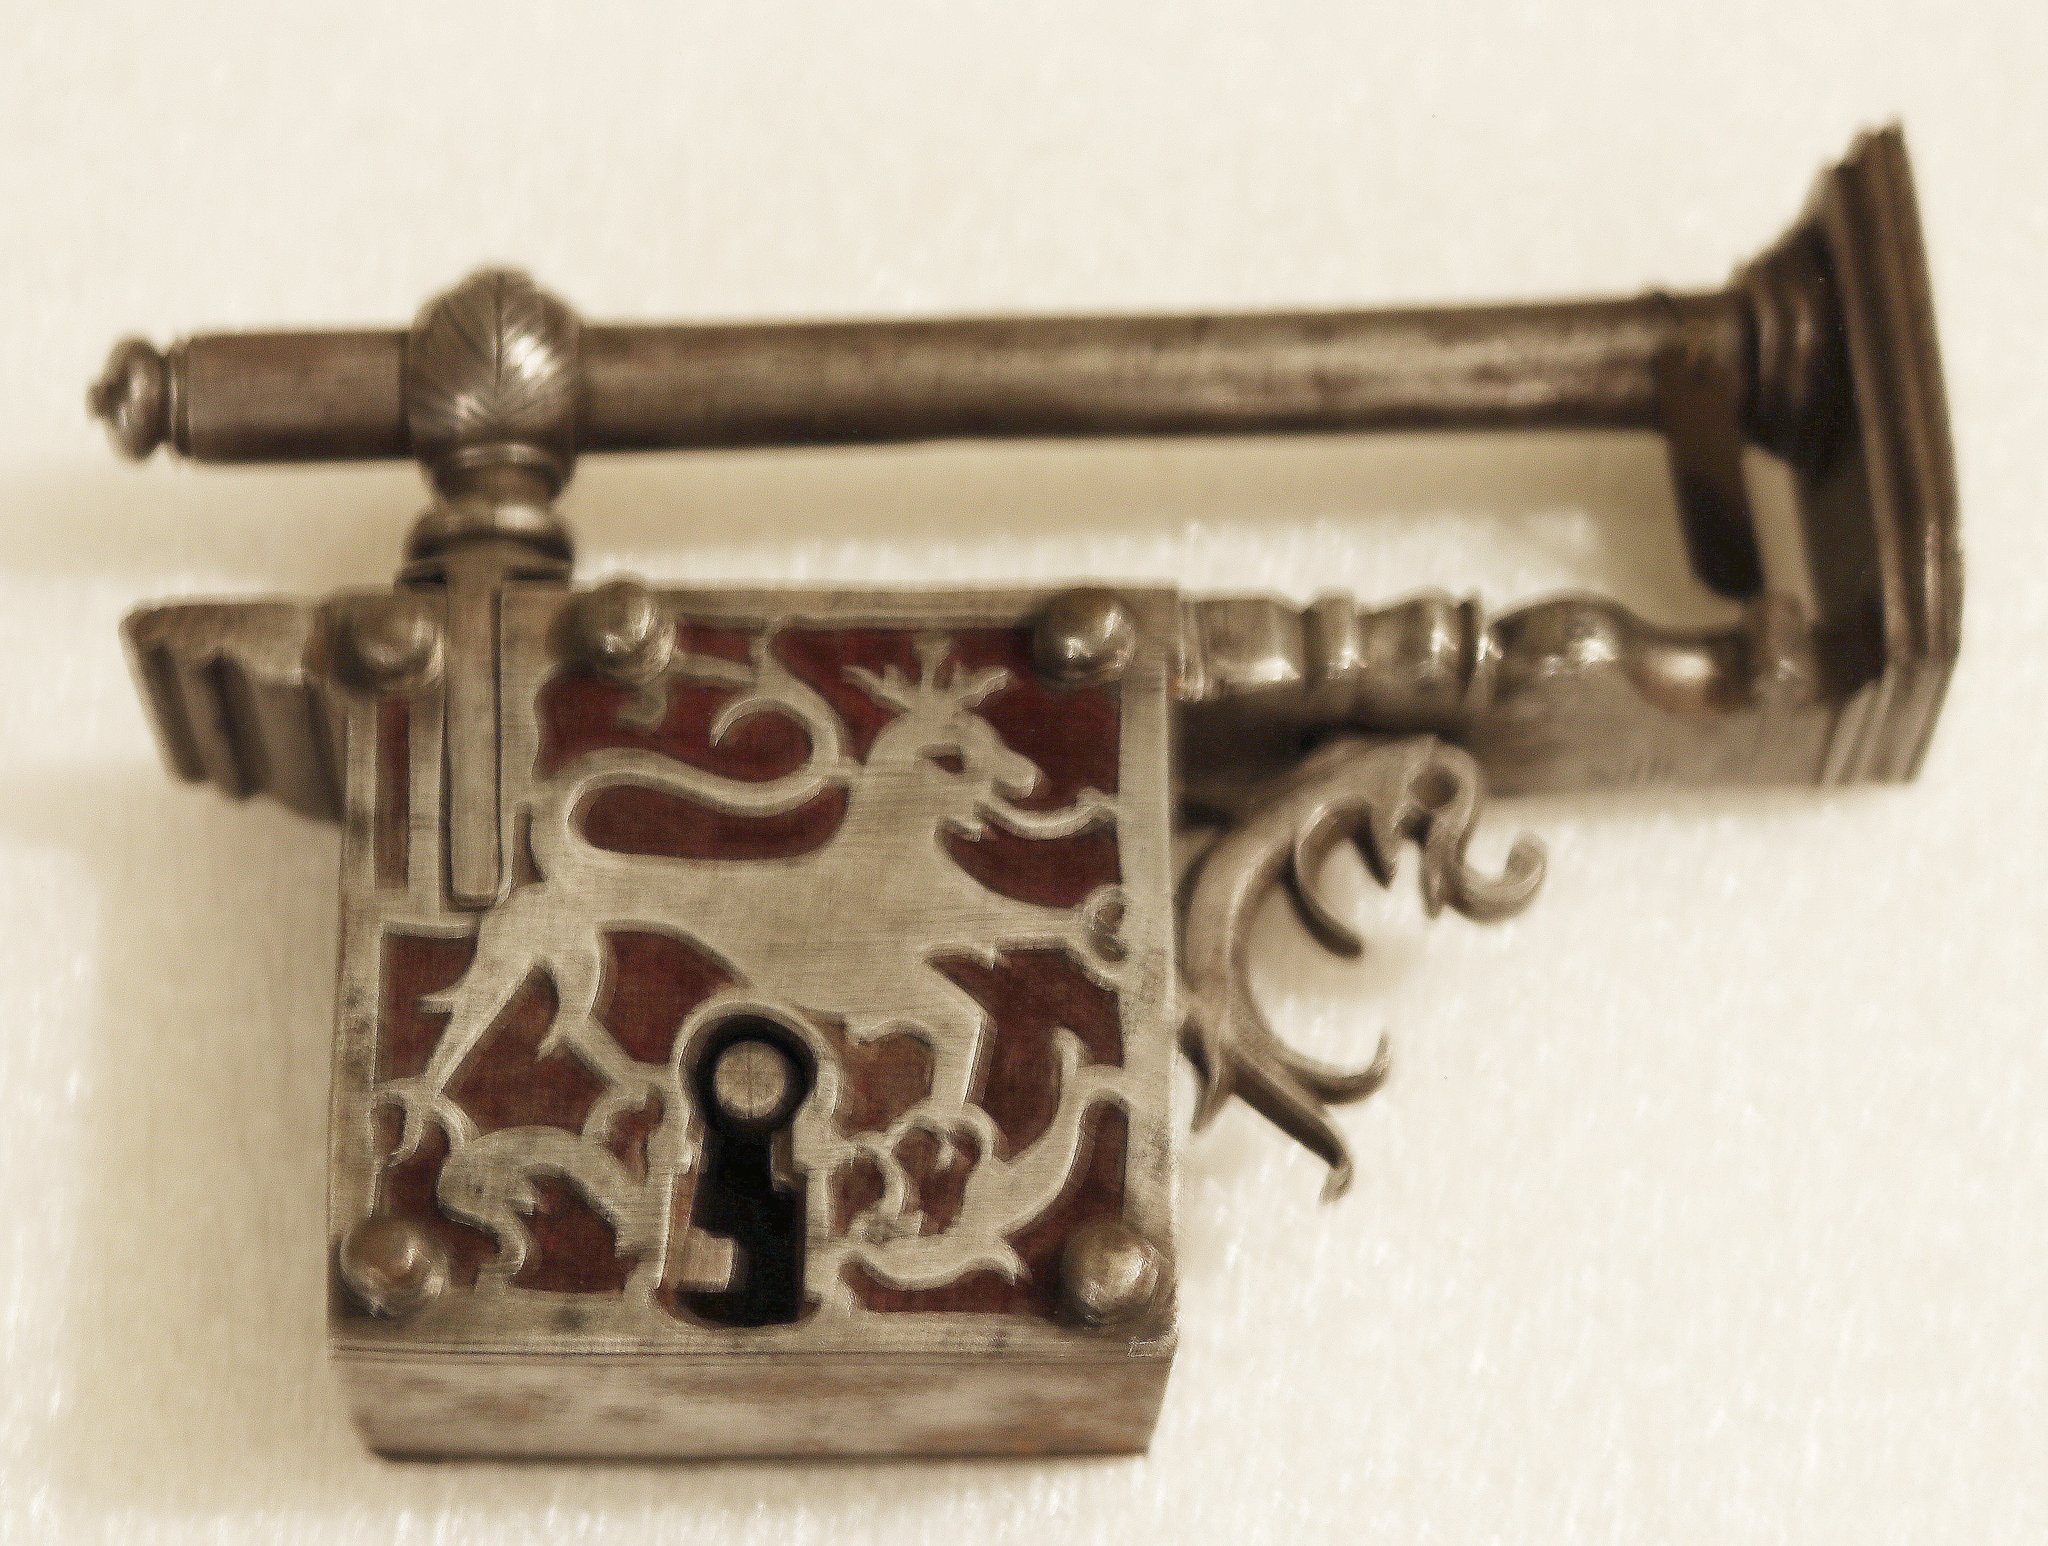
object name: padlock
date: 1601-1700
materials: iron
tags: lions